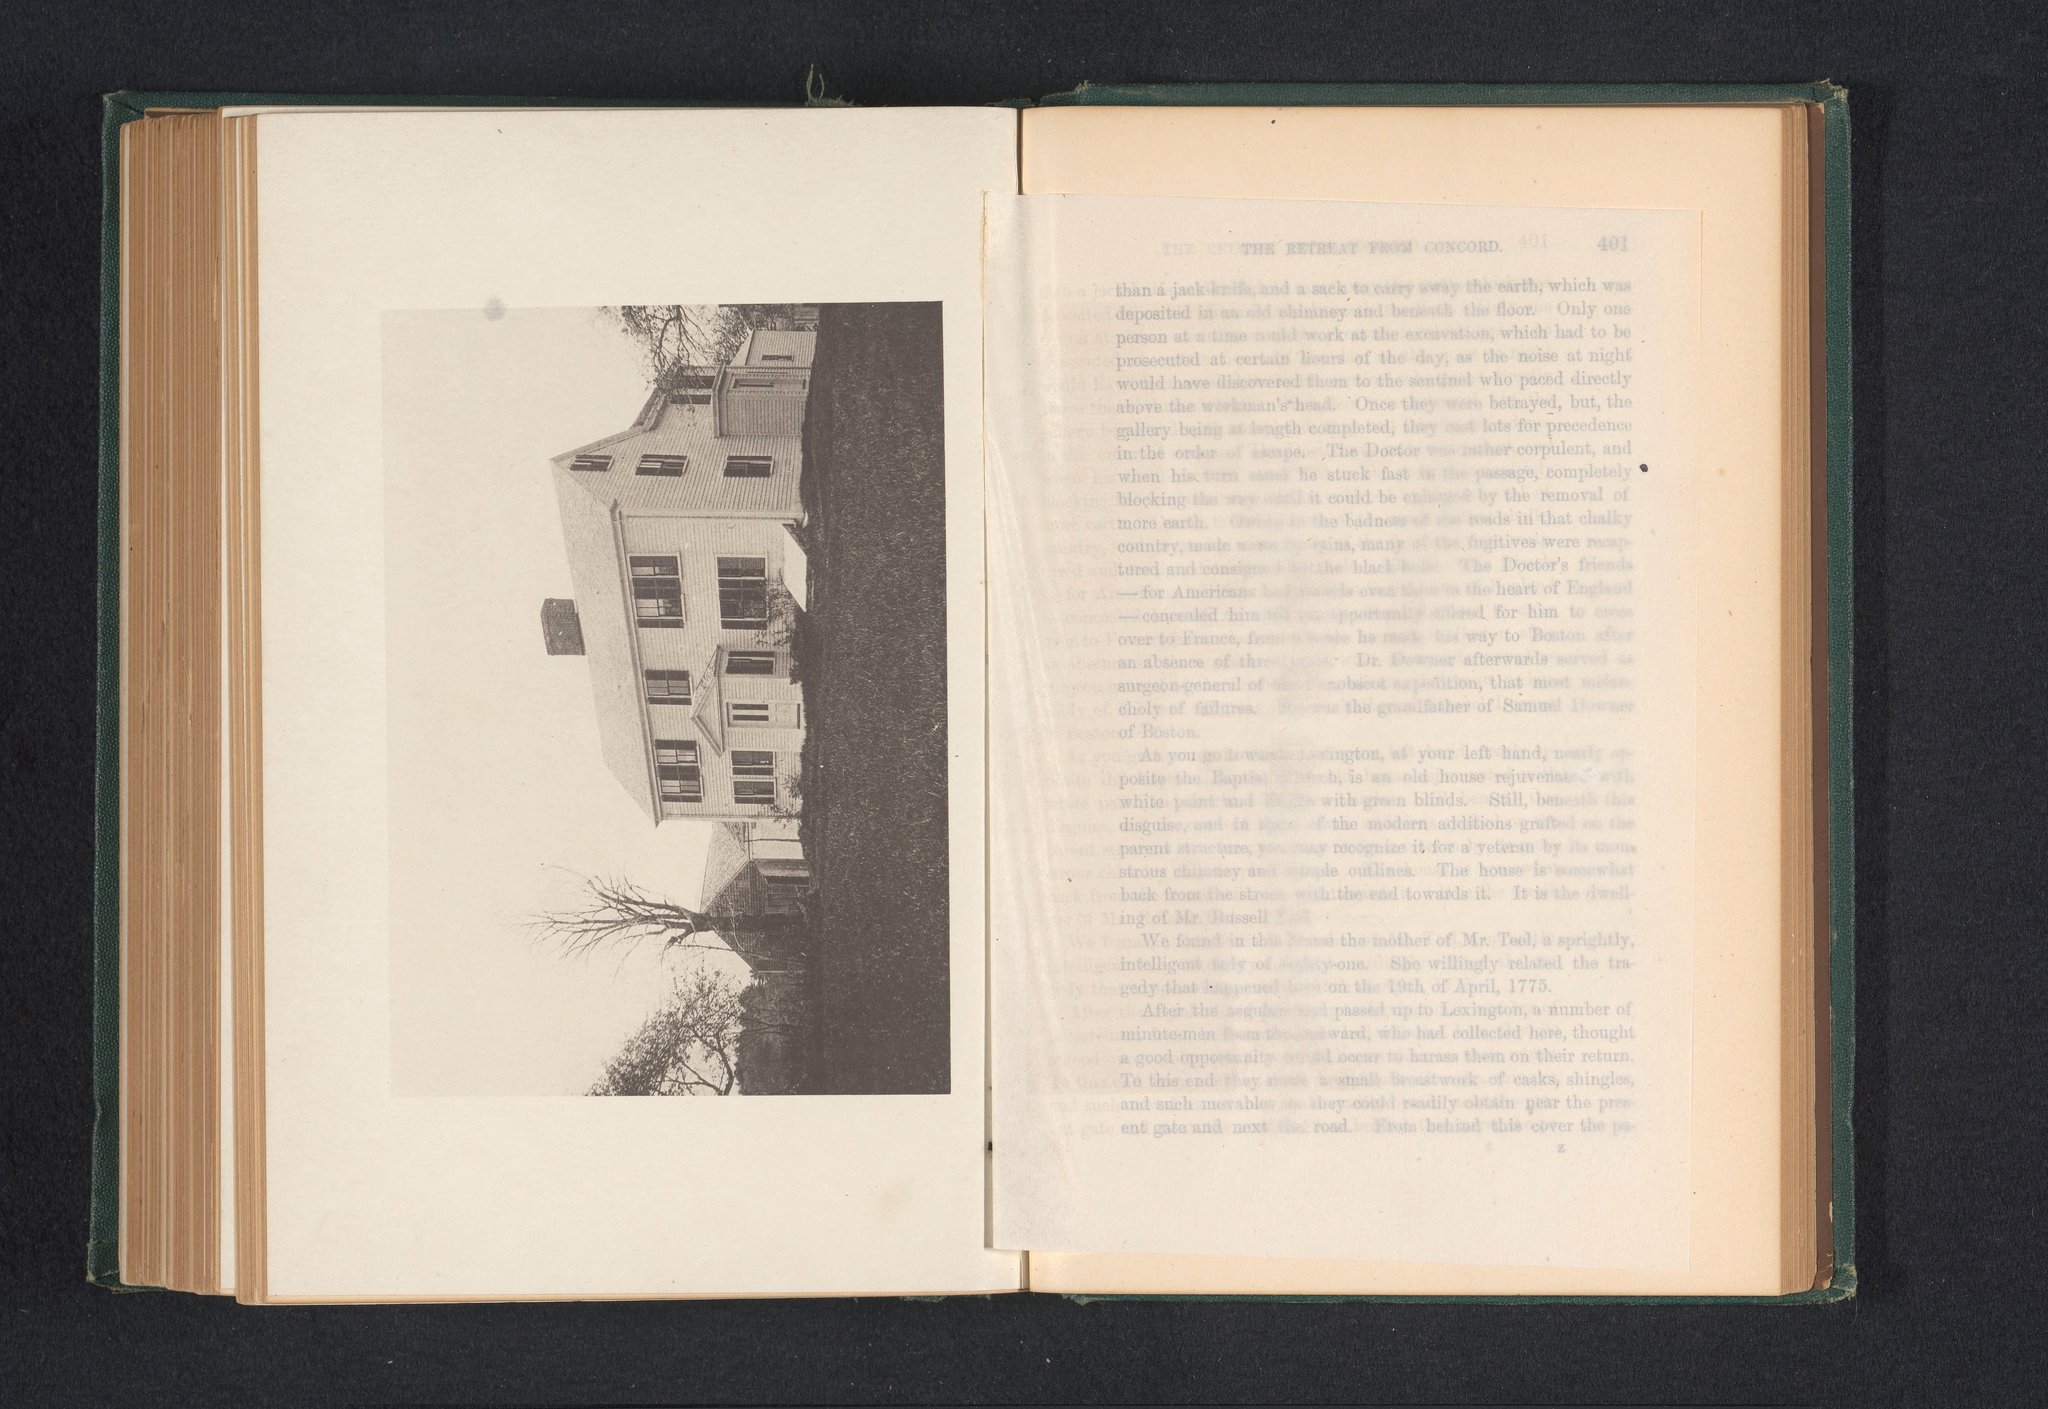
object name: page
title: Gezicht op het Jason Russell House te Concord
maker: Anonymous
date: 1869-1874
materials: paper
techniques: photograph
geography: concord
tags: rural housing, e.g. country-house, villa, cottage, façade (of house or building)